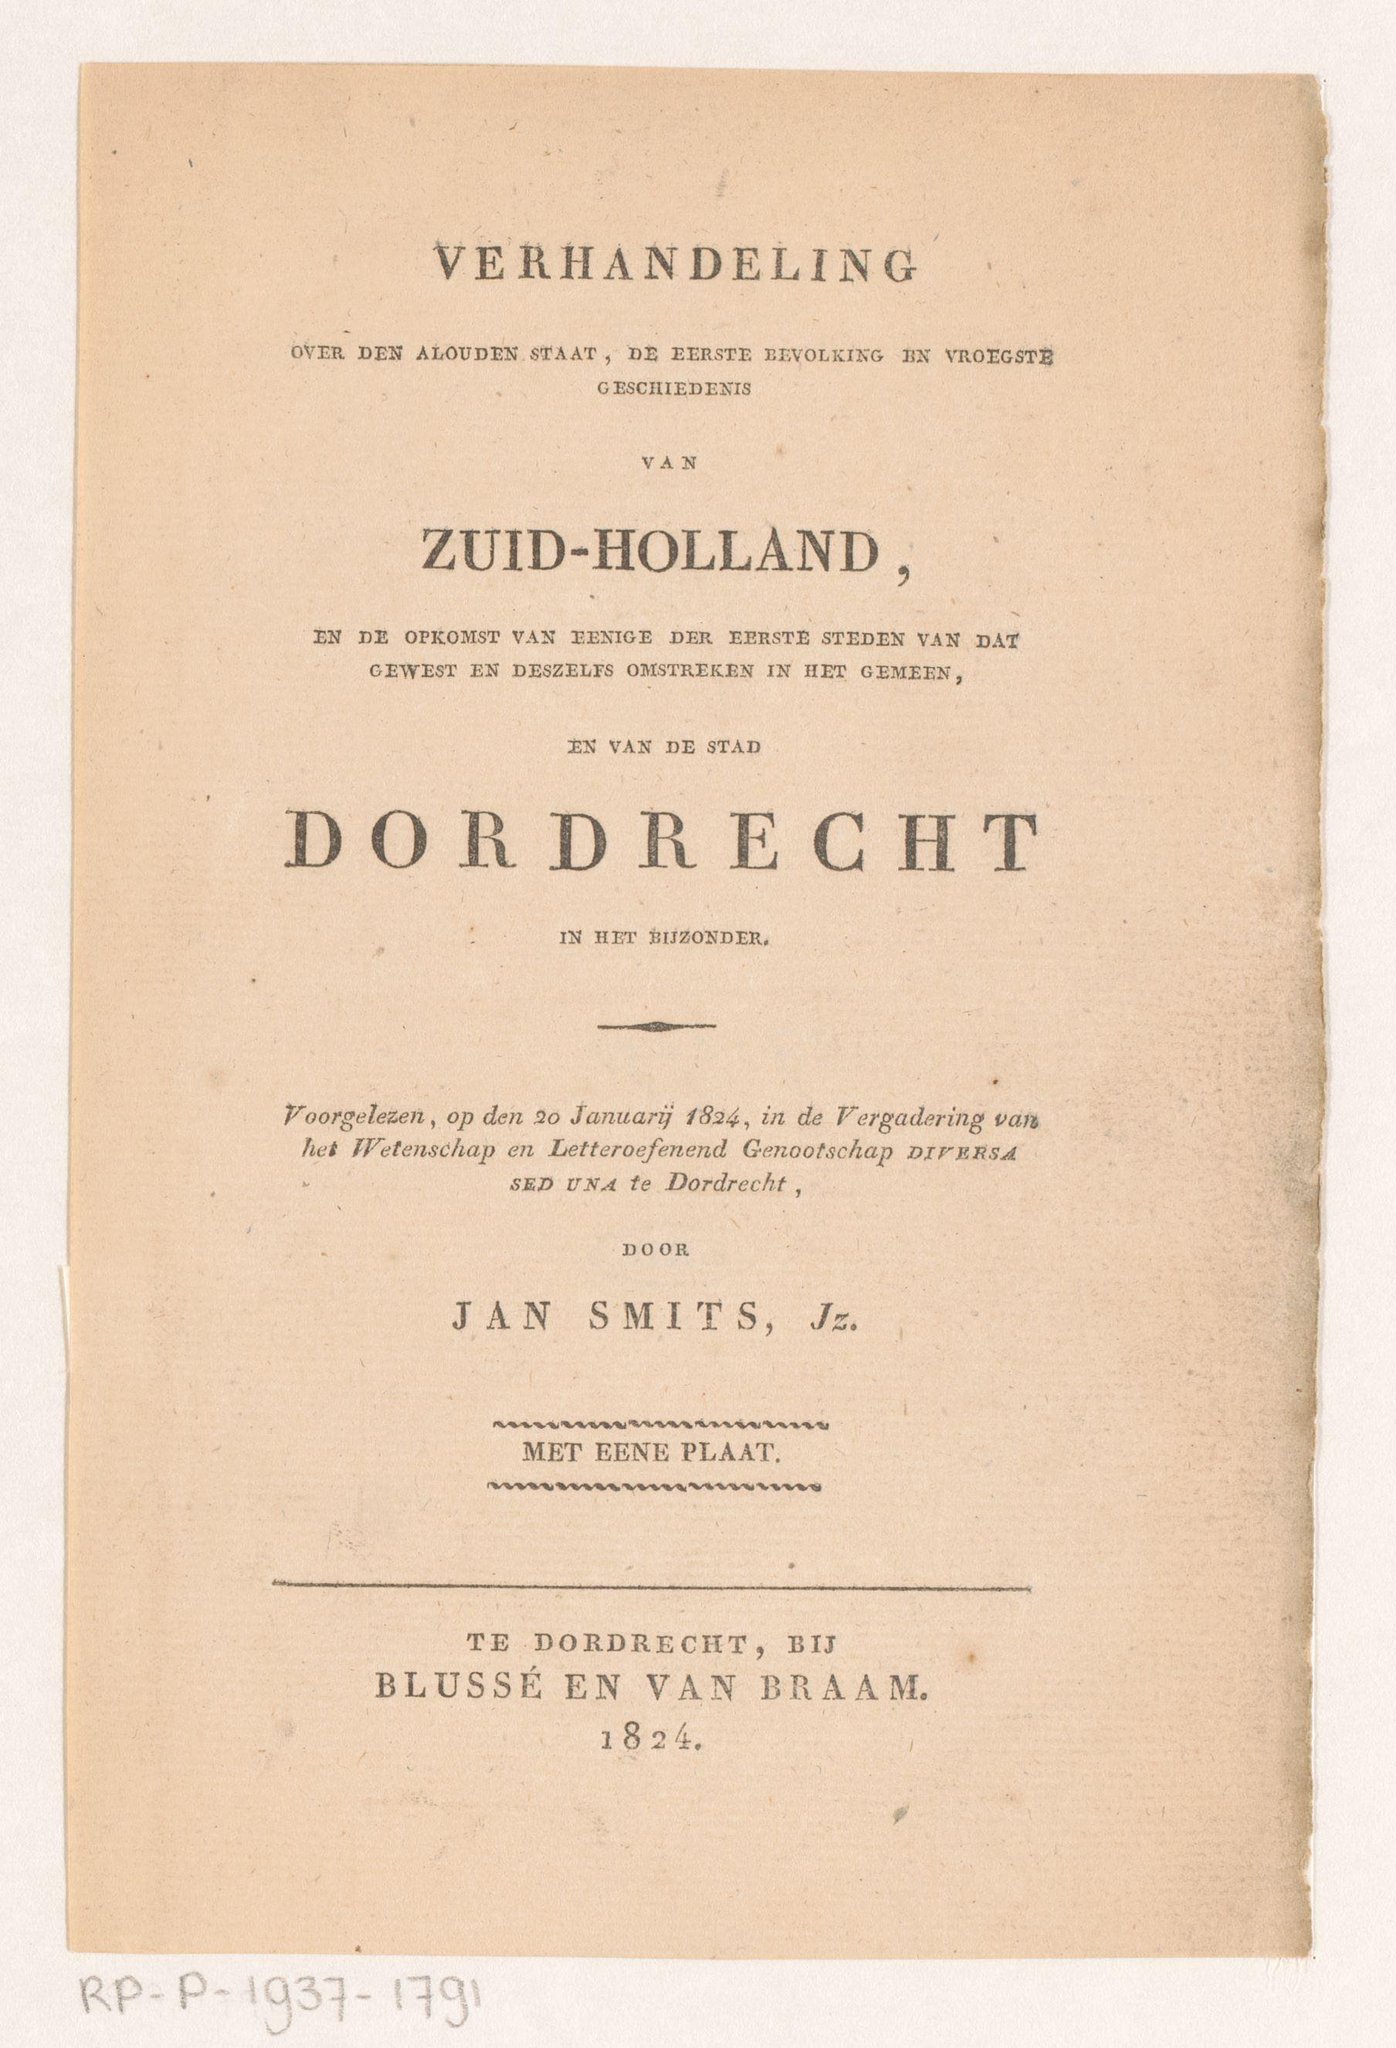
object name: titelblad, titelpagina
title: Titelpagina voor: Jan Smits, Verhandeling over den alouden staat, de eerste bevolking en vroegste geschiedenis van Zuid Holland (...) en van de stad Dordrecht in het bijzonder, 1824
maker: Anonymous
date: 1824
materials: paper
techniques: letterpress printing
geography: dordrecht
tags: title-page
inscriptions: collector's mark: Lugt 2228, collector's mark: Lugt 2760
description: Titelpagina voor: Smits, Jan. Verhandeling over den alouden staat, de eerste bevolking en vroegste geschiedenis van Zuid Holland (...) en van de stad Dordrecht in het bijzonder. Dordrecht: Blussé en Van Braam, 1824